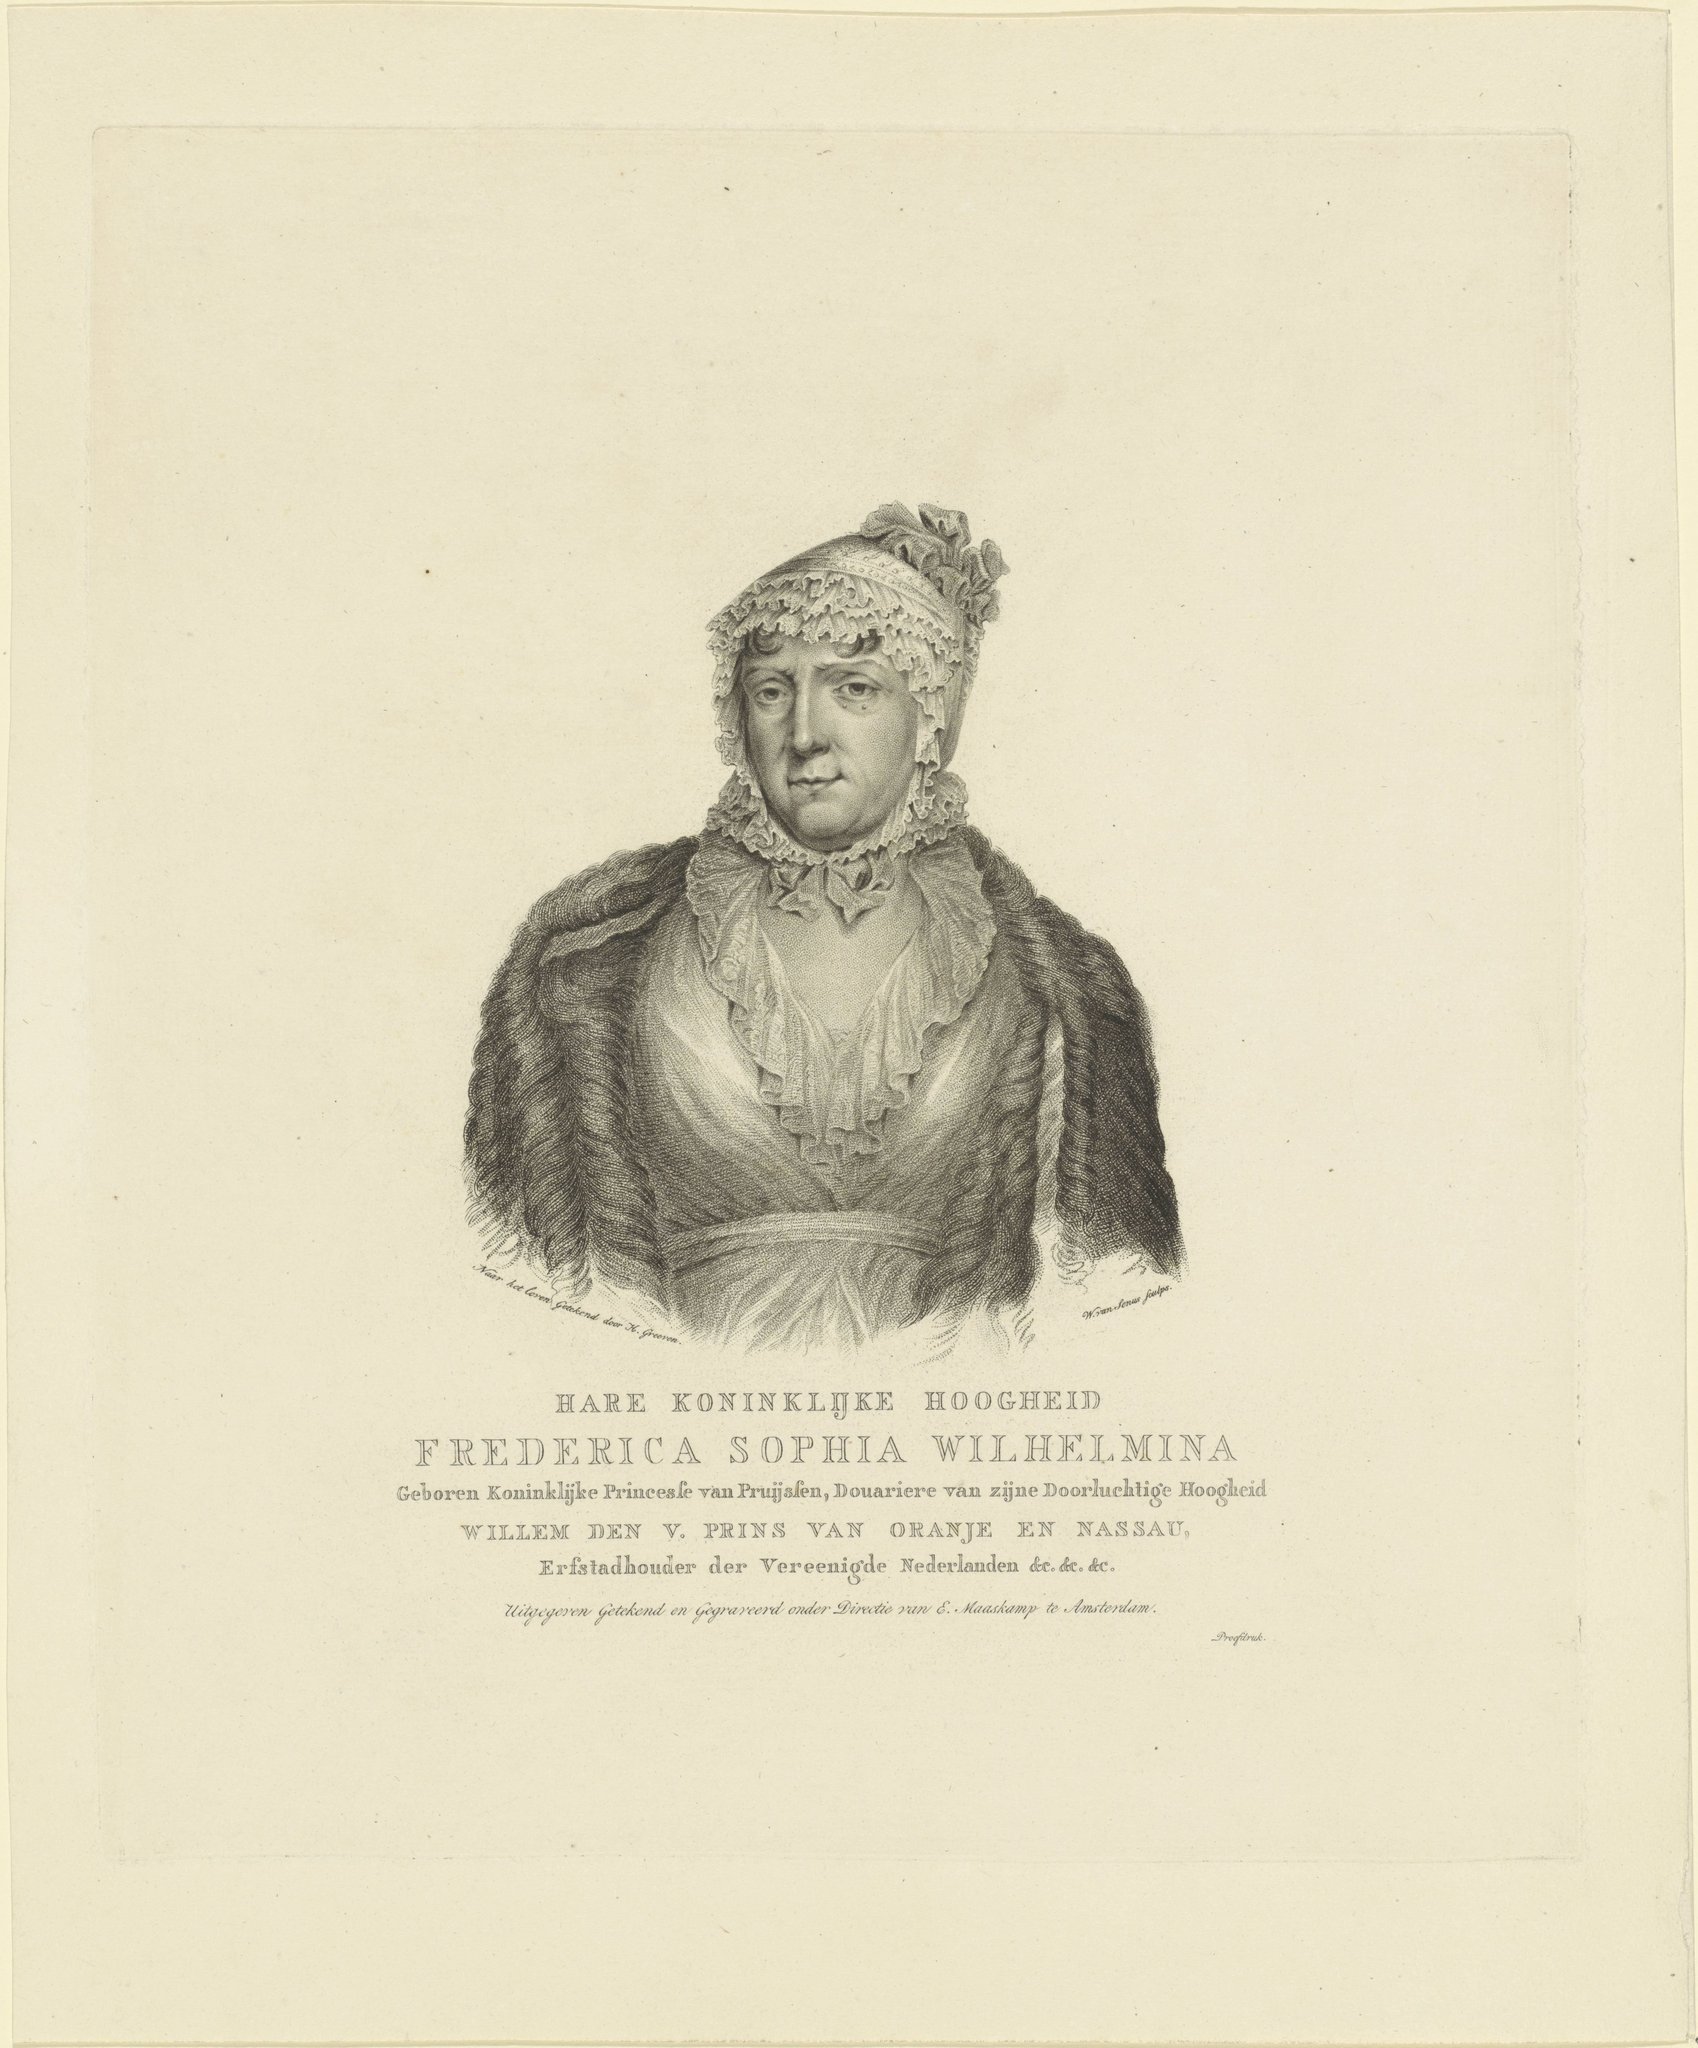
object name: print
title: Portret van Wilhelmina van Pruisen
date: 1815-1851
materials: paper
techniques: engraving, etching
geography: netherlands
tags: berlin, painter, draughtsman, wilhelmina of prussia (princess of orange)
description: Portret van Wilhelmina. In de ondermarge vijf regels Nederlandse tekst. Rechtsonder 'Proefdruk'.